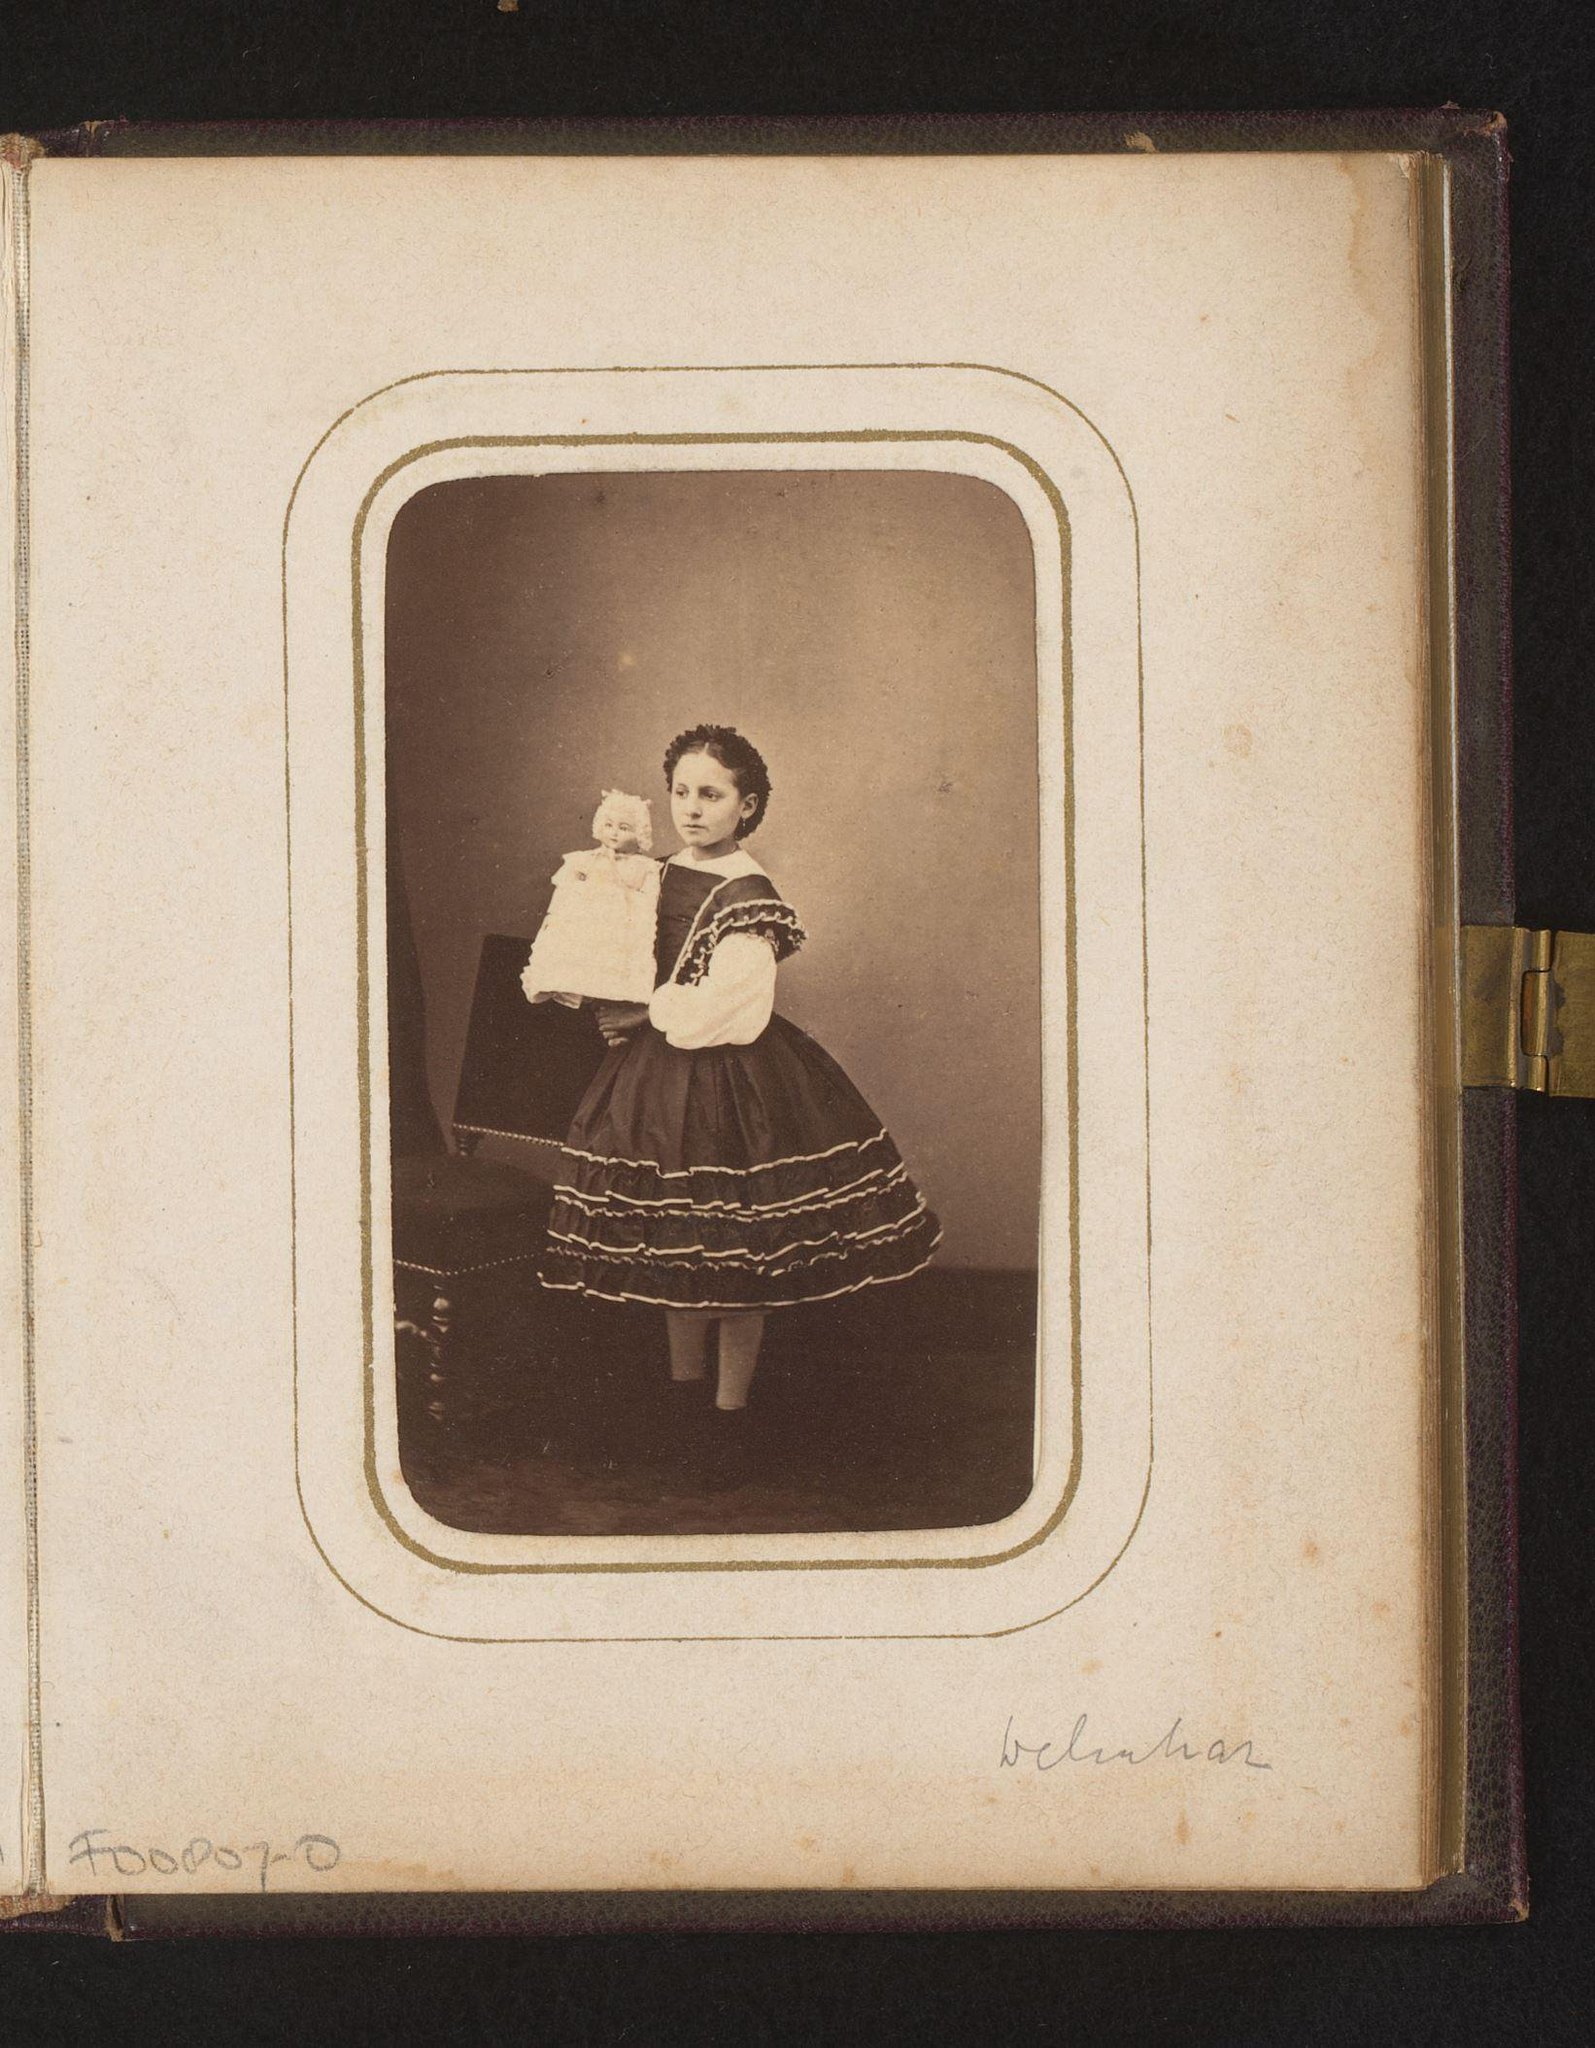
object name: carte de visite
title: Portret van een staand meisje met pop in de hand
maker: françois joseph delintraz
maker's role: fotograaf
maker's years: 1827-1886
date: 1860-1900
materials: cardboard, photographic support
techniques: albumen print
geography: paris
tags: historical persons - bb - woman, (playing with) dolls, child between toddler and youth (of undetermined sex)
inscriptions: annotation: ‘Delintraz’, inscription: ‘15, RUE DUPHOT, 15/ en face l'Egse de la Madeleine/ a l'Entée du Bart./ DELINTRAZ/ PHOTOGRAPHE/ Specialité de/ REPRODUCTIONS/ en tous genres./ PARIS.’